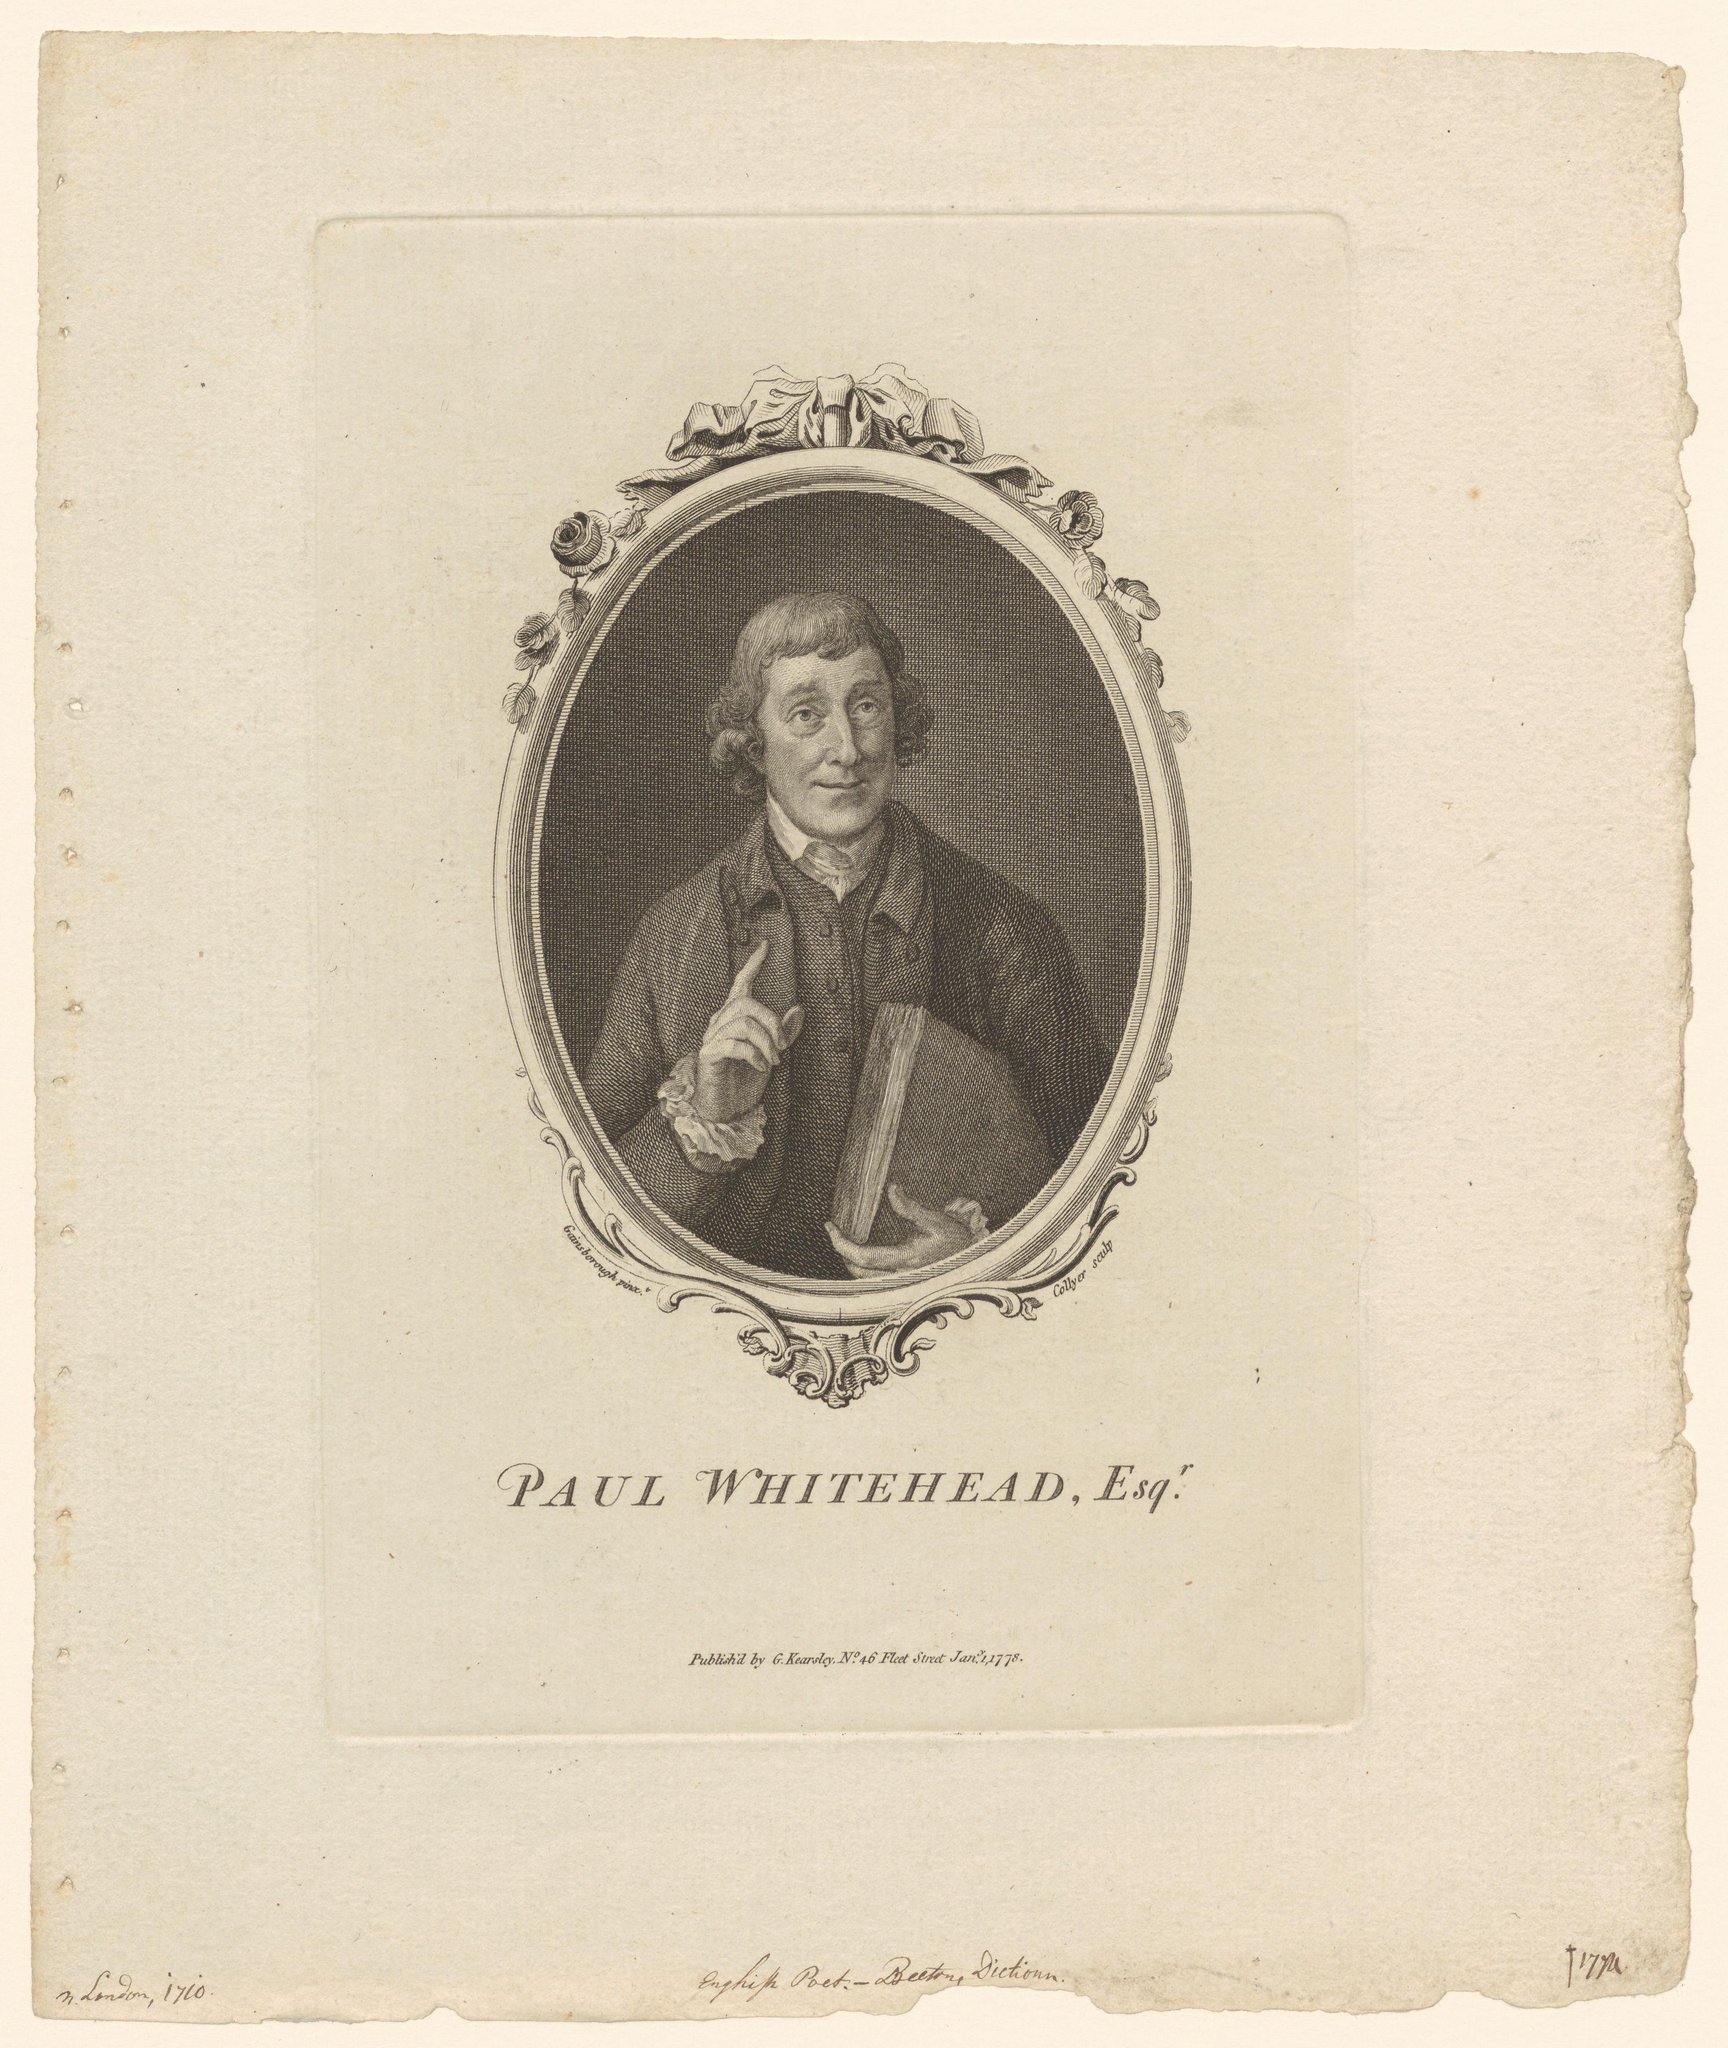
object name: print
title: Portret van Paul Whitehead Esqr.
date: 1778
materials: paper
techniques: engraving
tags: london, paul whitehead, historical persons, portrait of a writer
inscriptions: collector's mark: Lugt 2228